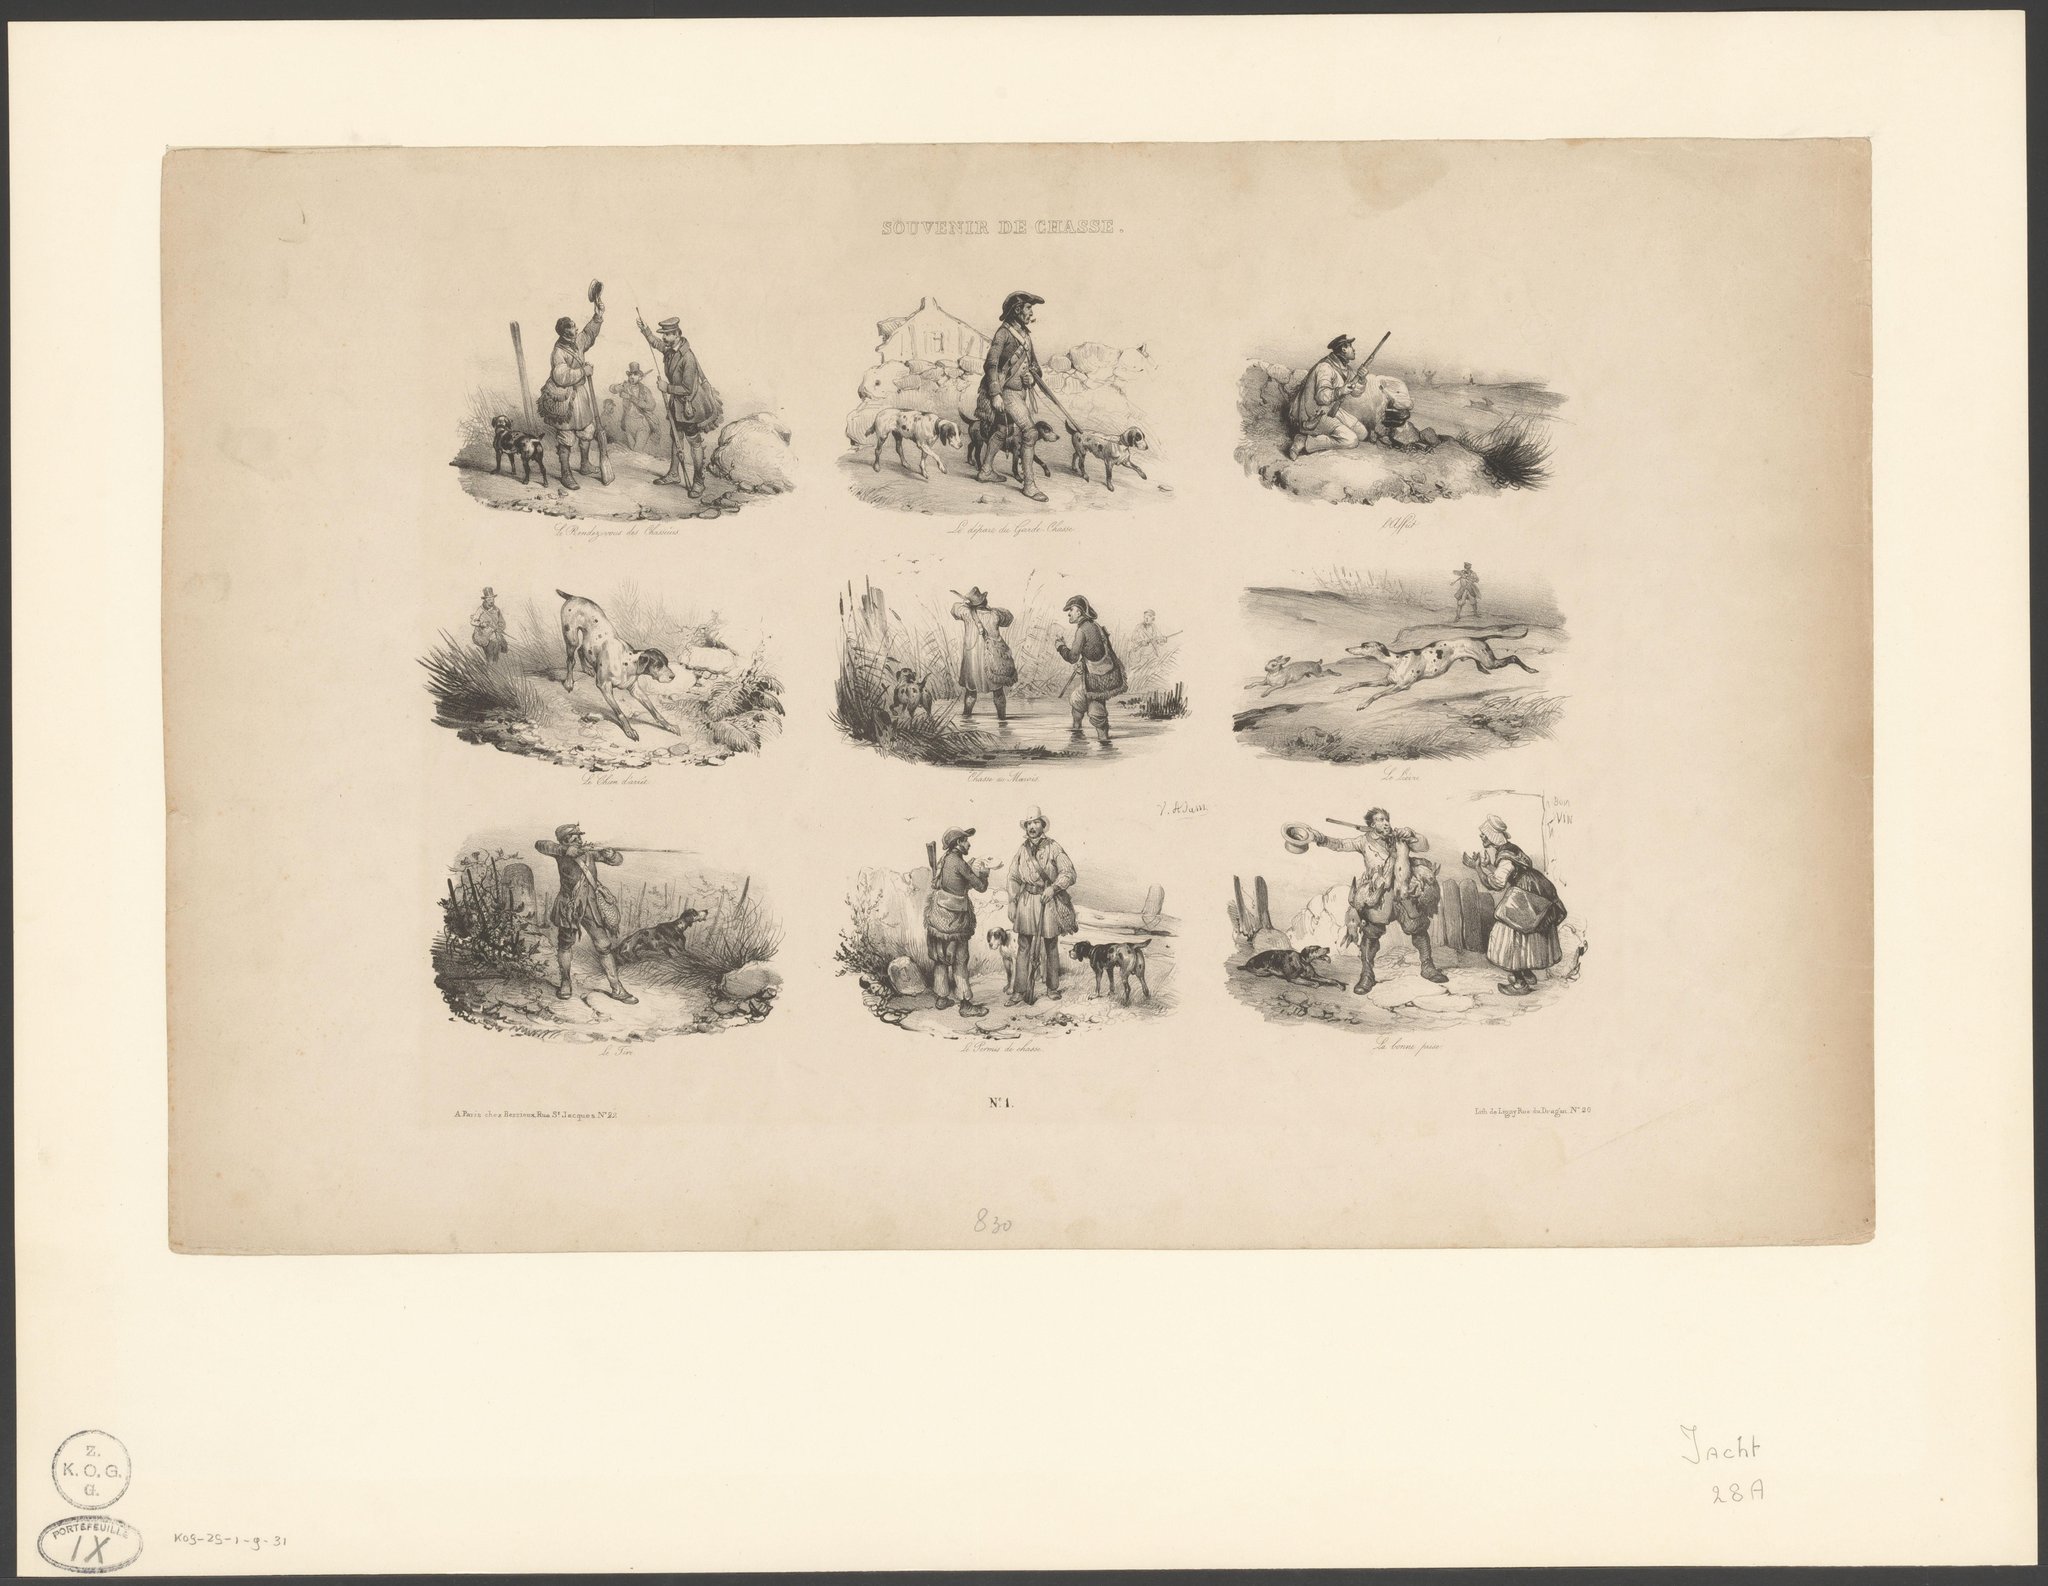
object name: print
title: Negen voorstellingen van de jacht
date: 1827-1873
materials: paper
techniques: lithograph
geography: paris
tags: hunter, game, hunted animals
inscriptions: collector's mark: Lugt 1641, stamp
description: Negen voorstellingen over de jacht, van de samenkomst van de jagers tot de goede terugkomst. Onderaan genummerd: No. 1. Onderwerpsrubrieken binnen de Atlas Zeden en Gewoonten: Handel, nijverheid en verkeer, jacht.